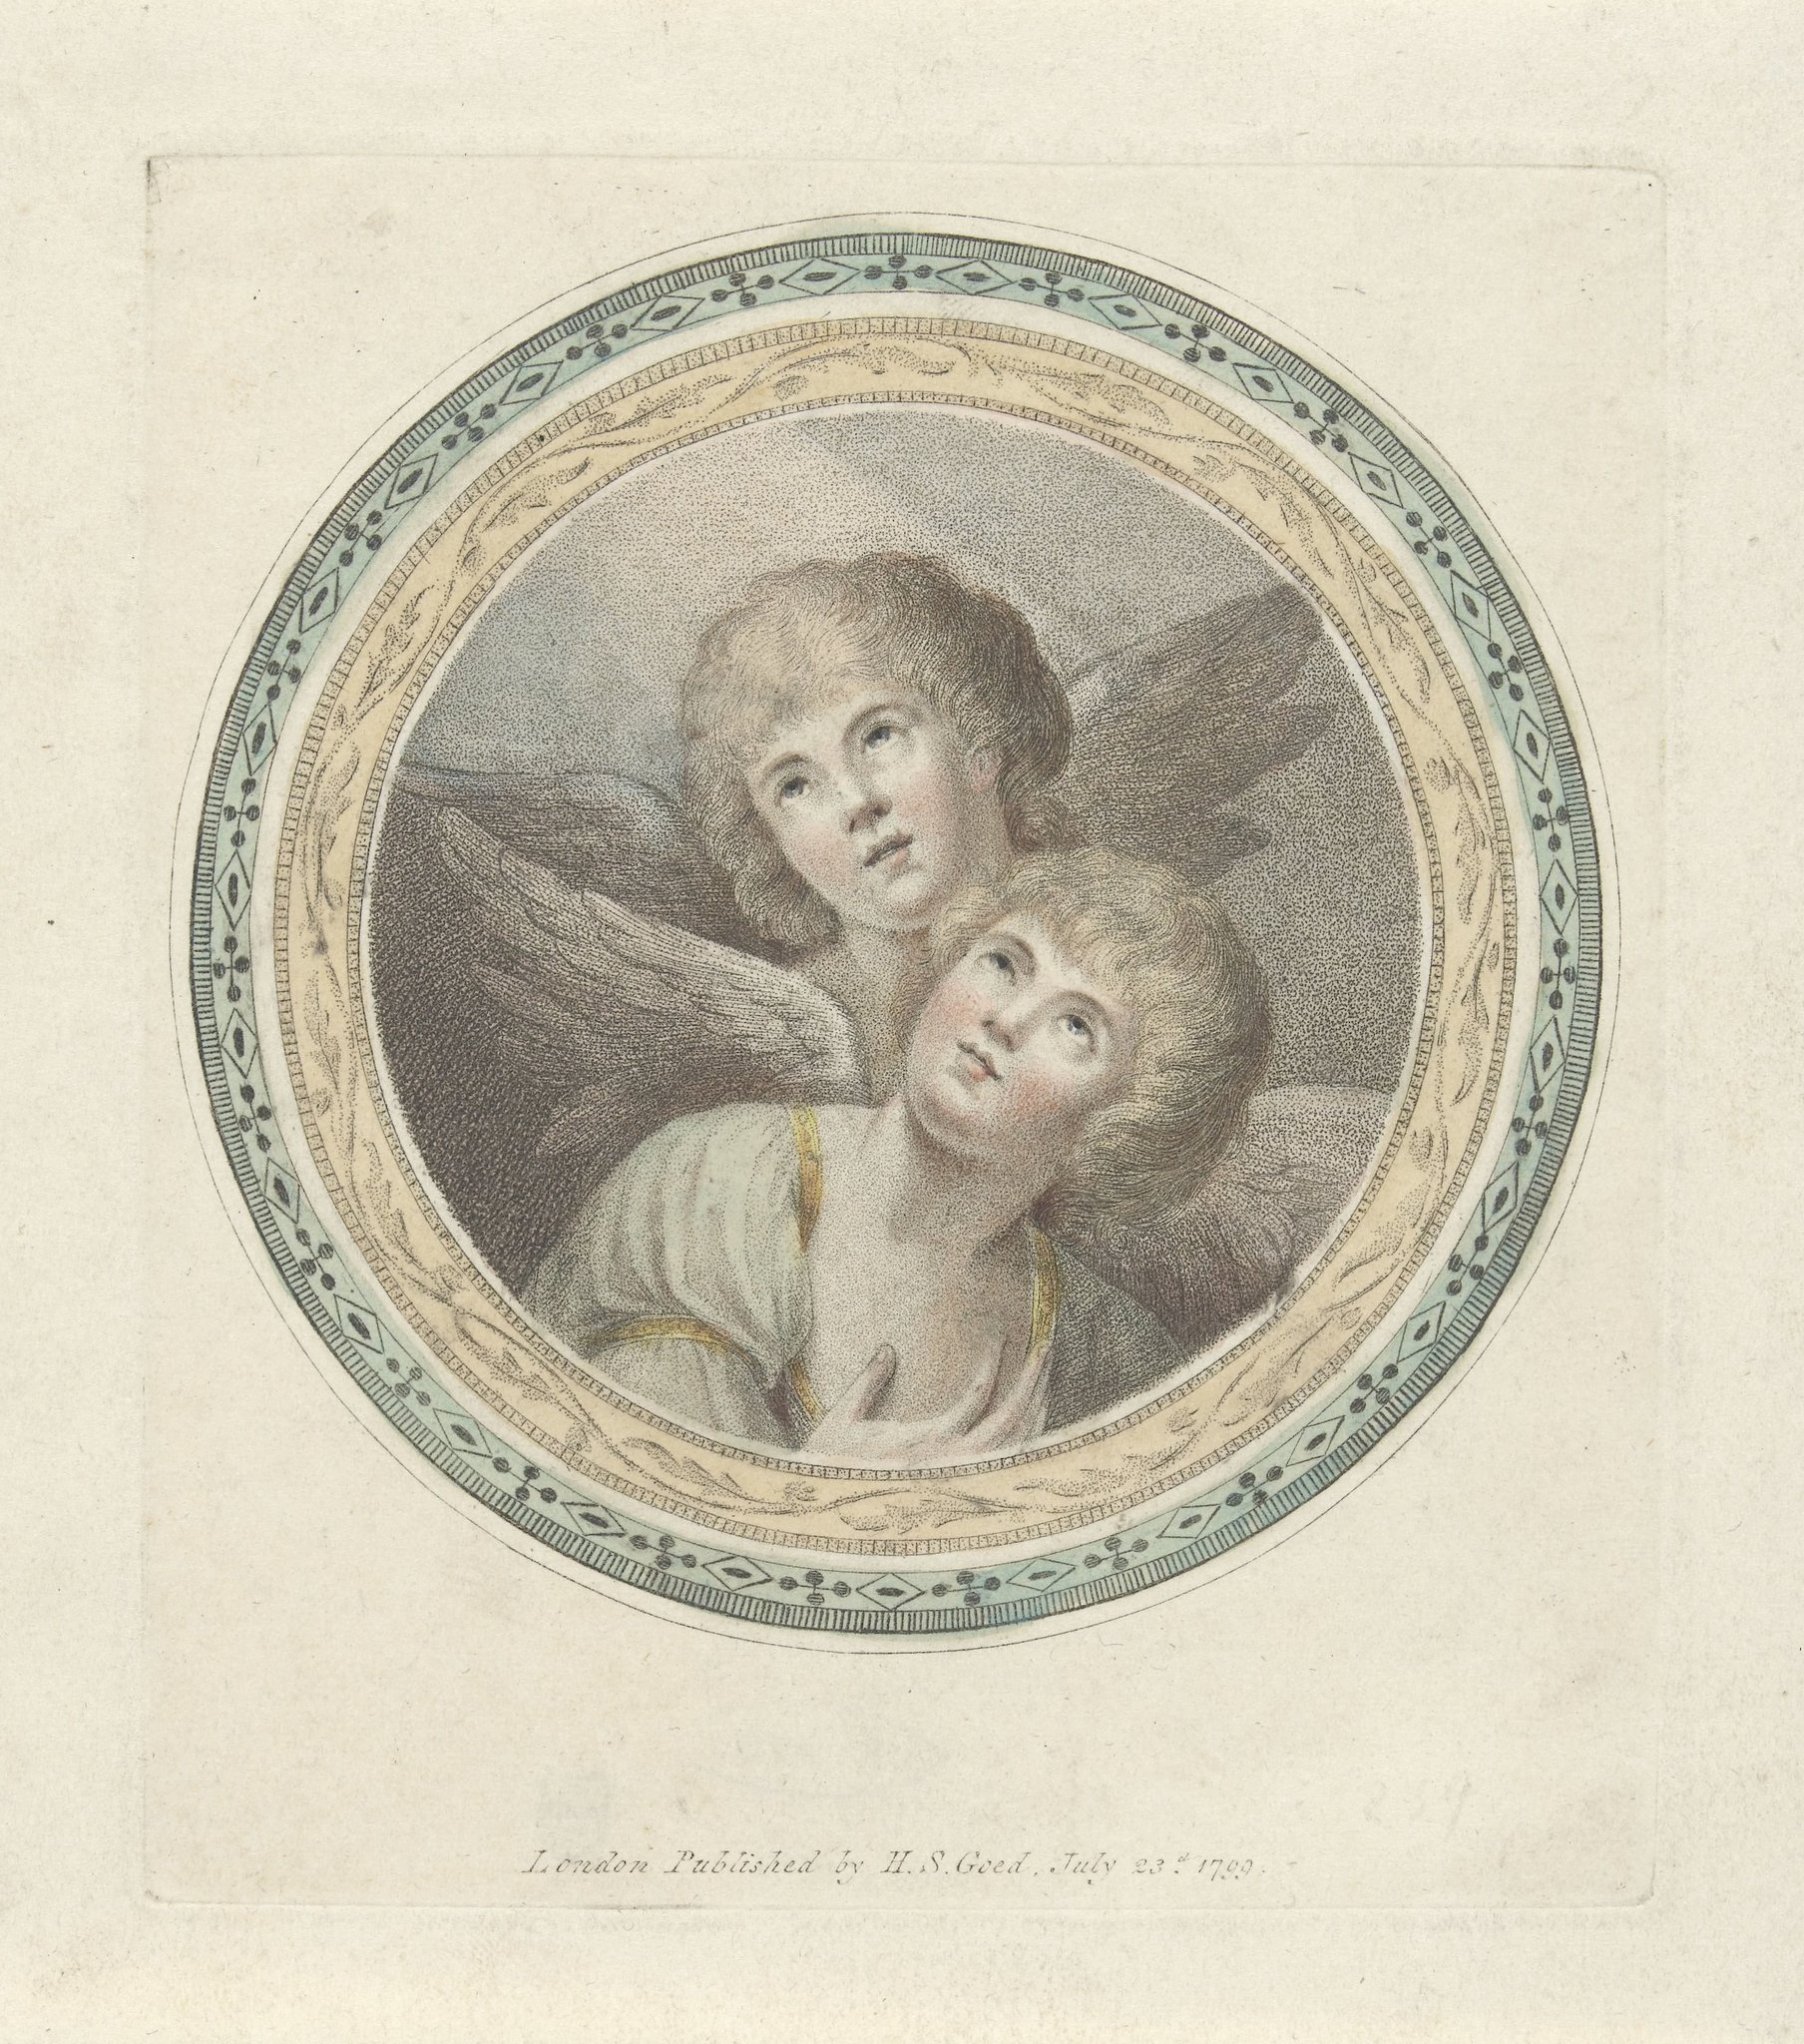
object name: print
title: Twee engelen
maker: charles howard hodges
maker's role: draughtsman, painter, print maker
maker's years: 1764-1837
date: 1799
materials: paper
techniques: etching, hand coloring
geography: london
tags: angels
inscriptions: collector's mark: Lugt 2760, collector's mark: Lugt 2228, collector's mark: Lugt 1272